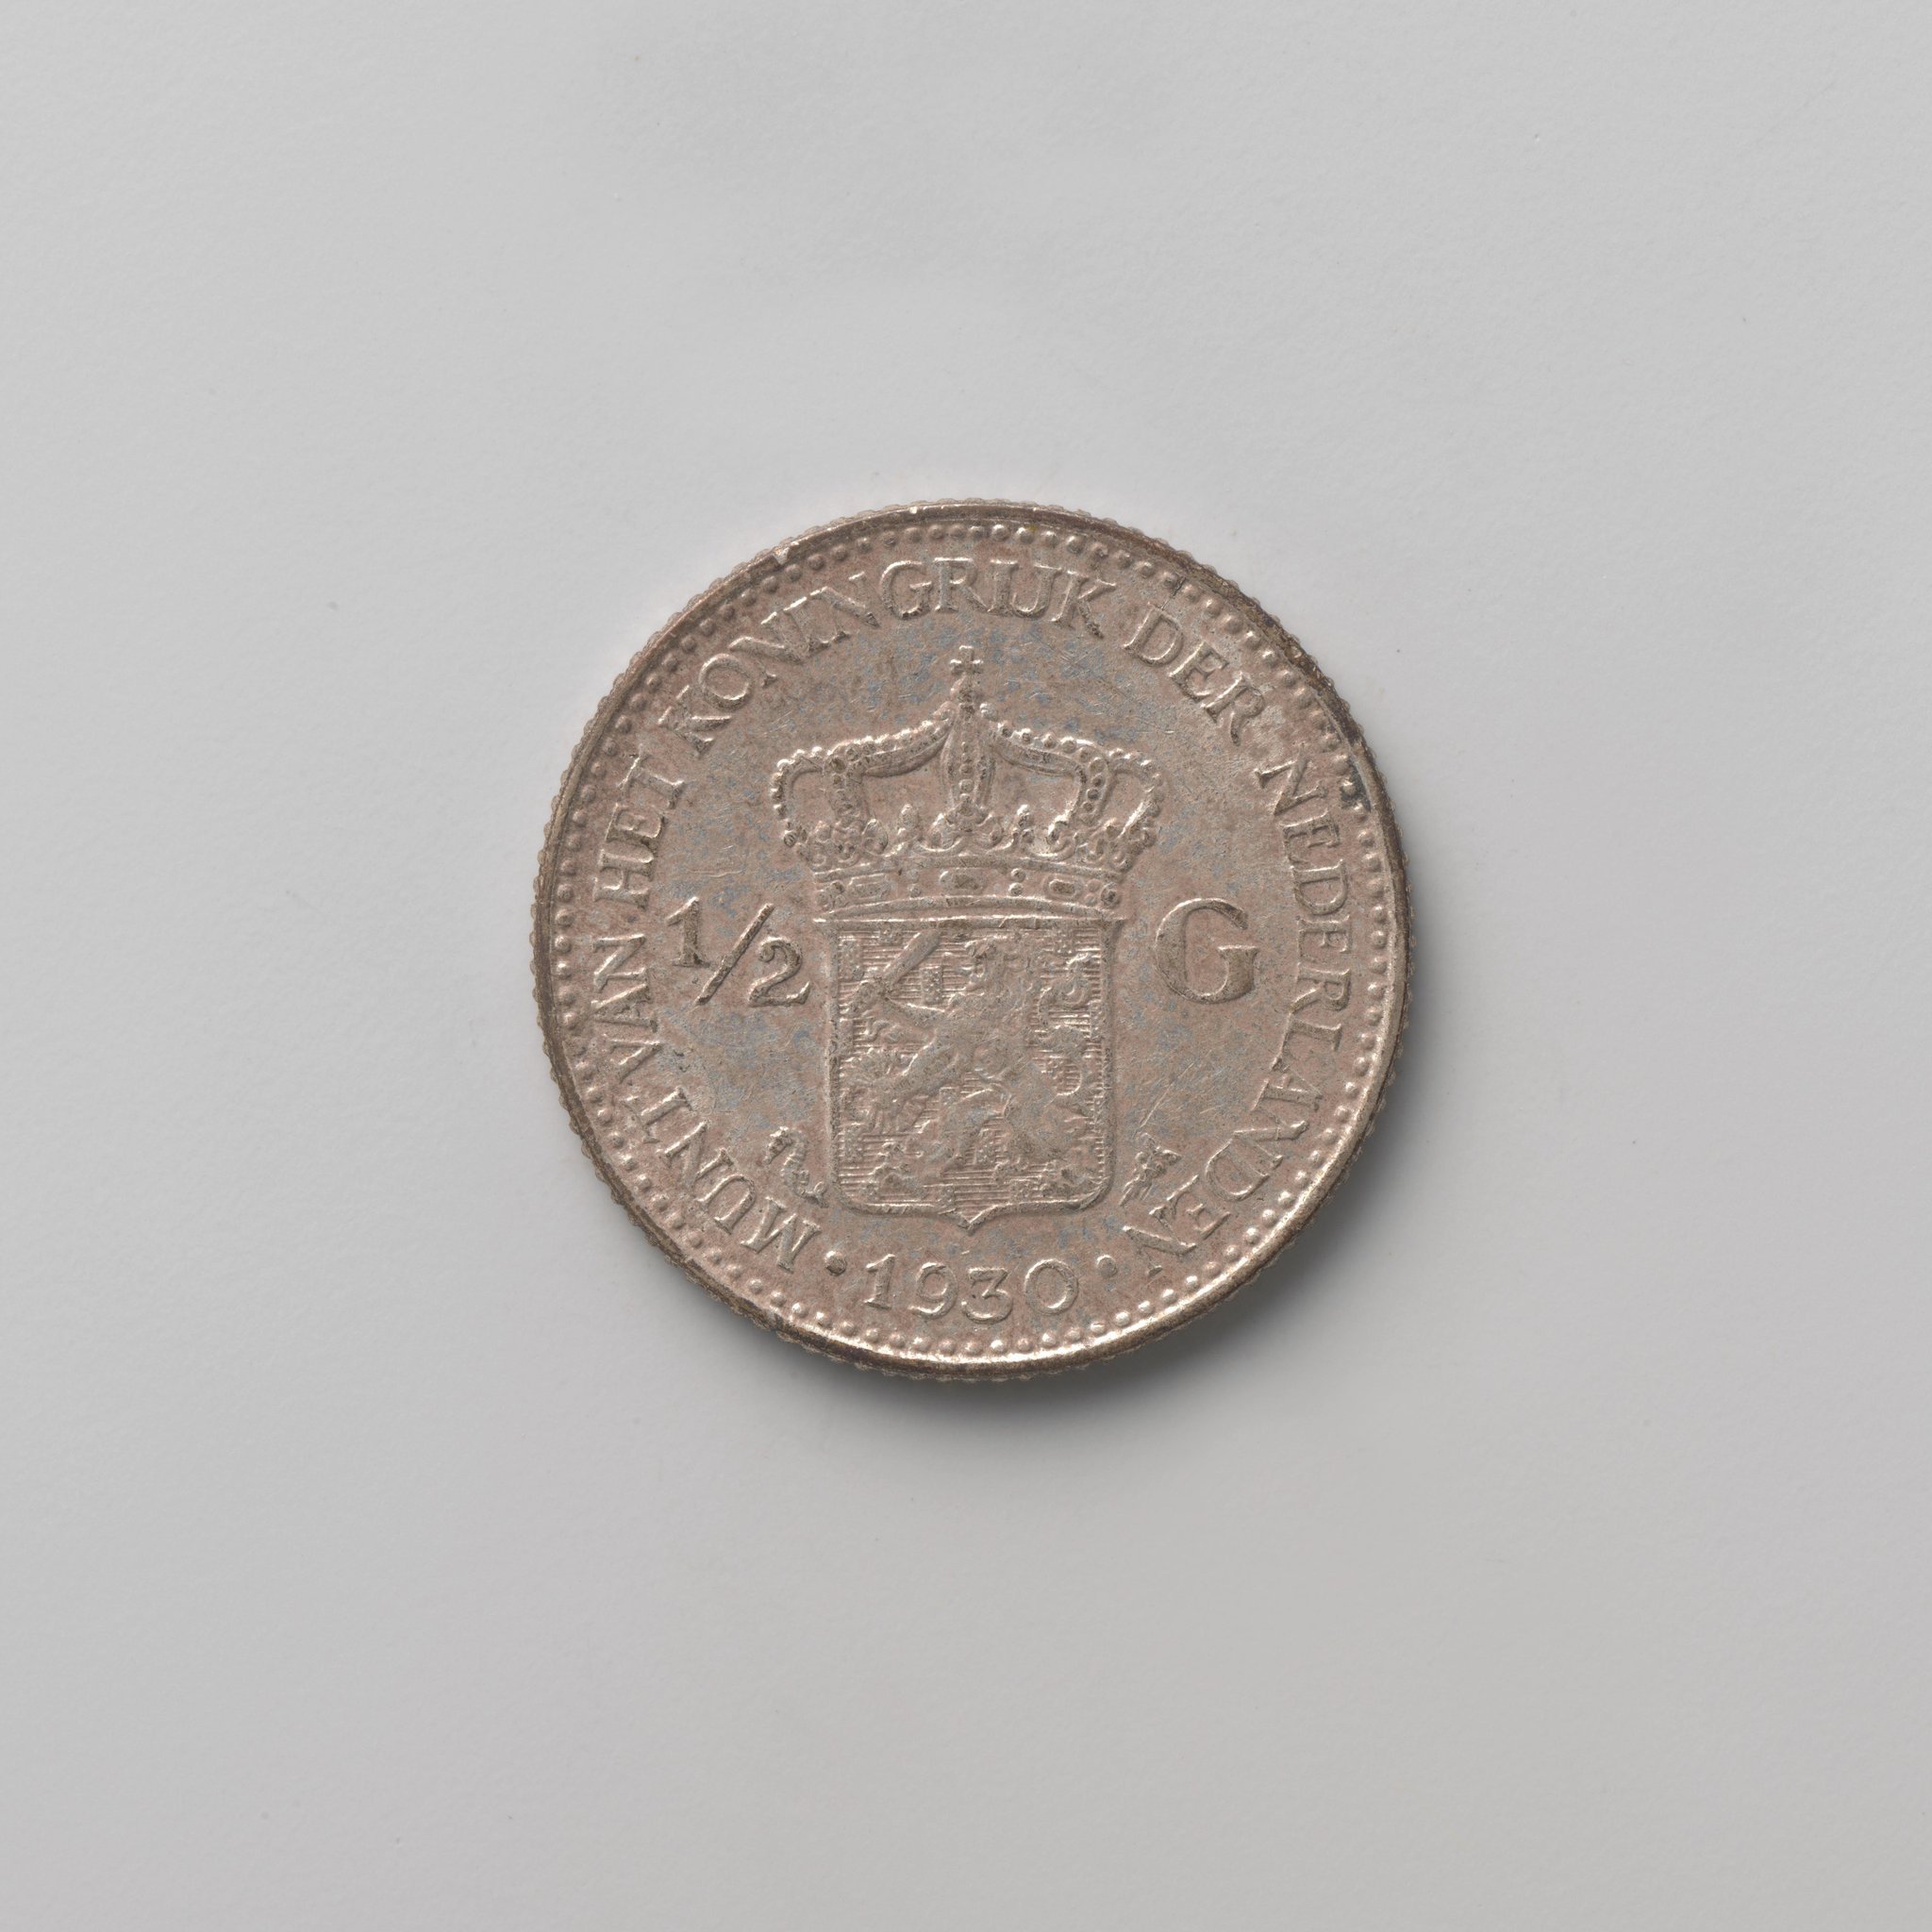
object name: coin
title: Nederlandse ½ gulden,1930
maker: wilhelmina of the netherlands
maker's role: print maker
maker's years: 1880-1962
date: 1930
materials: silver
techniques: striking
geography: utrecht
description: Zilveren munt. Voorzijde: hoofd naar links. Keerzijde: tussen waarde-aanduiding ½ G gekroond rijkswapenschild. Jaartal onderaan in omschrift. Kartelrand.